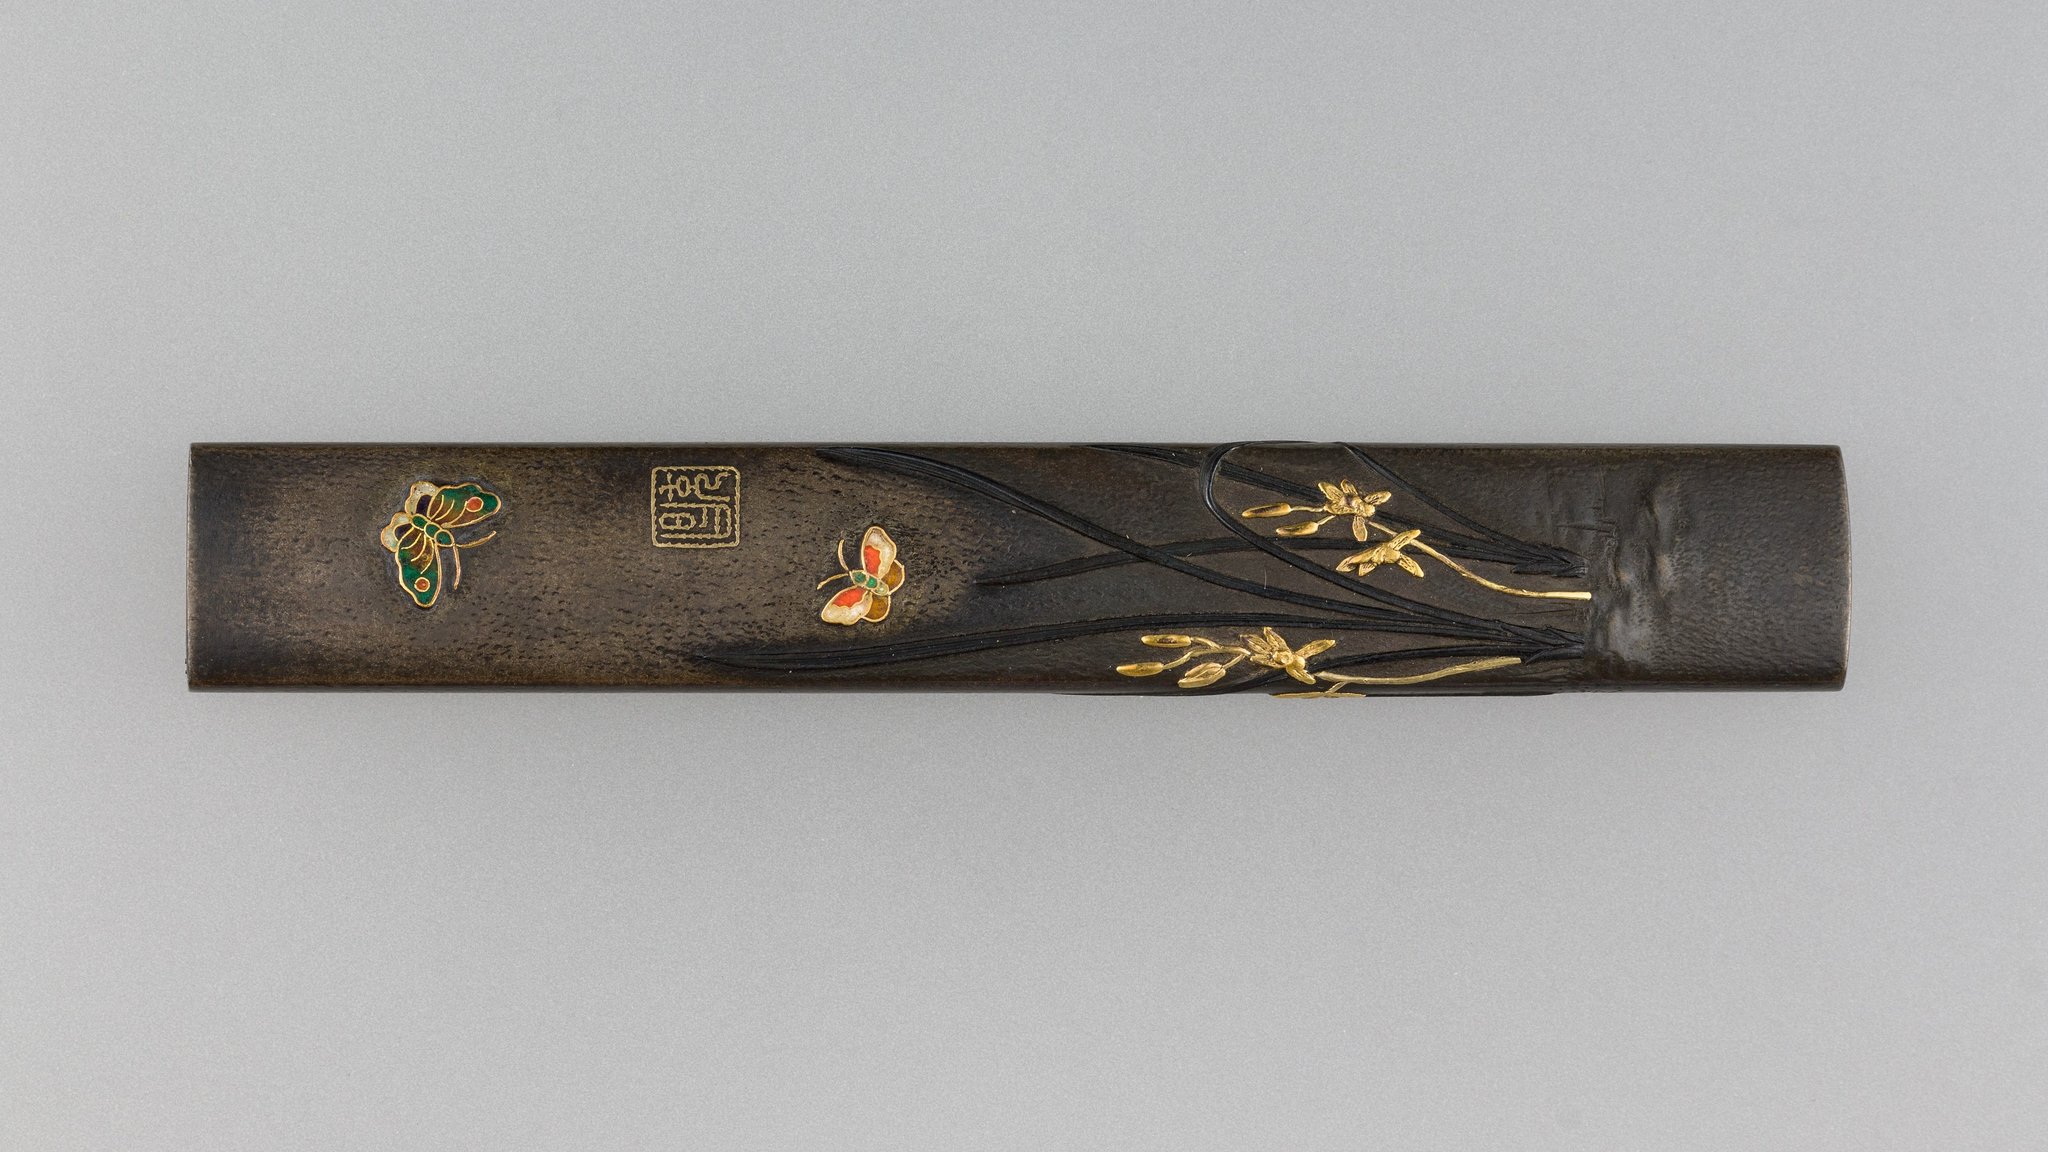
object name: knife handle kozuka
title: Knife Handle (Kozuka)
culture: japanese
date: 1721-1777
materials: gold alloy, silver alloy, enamel, gold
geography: japan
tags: butterflies,plants